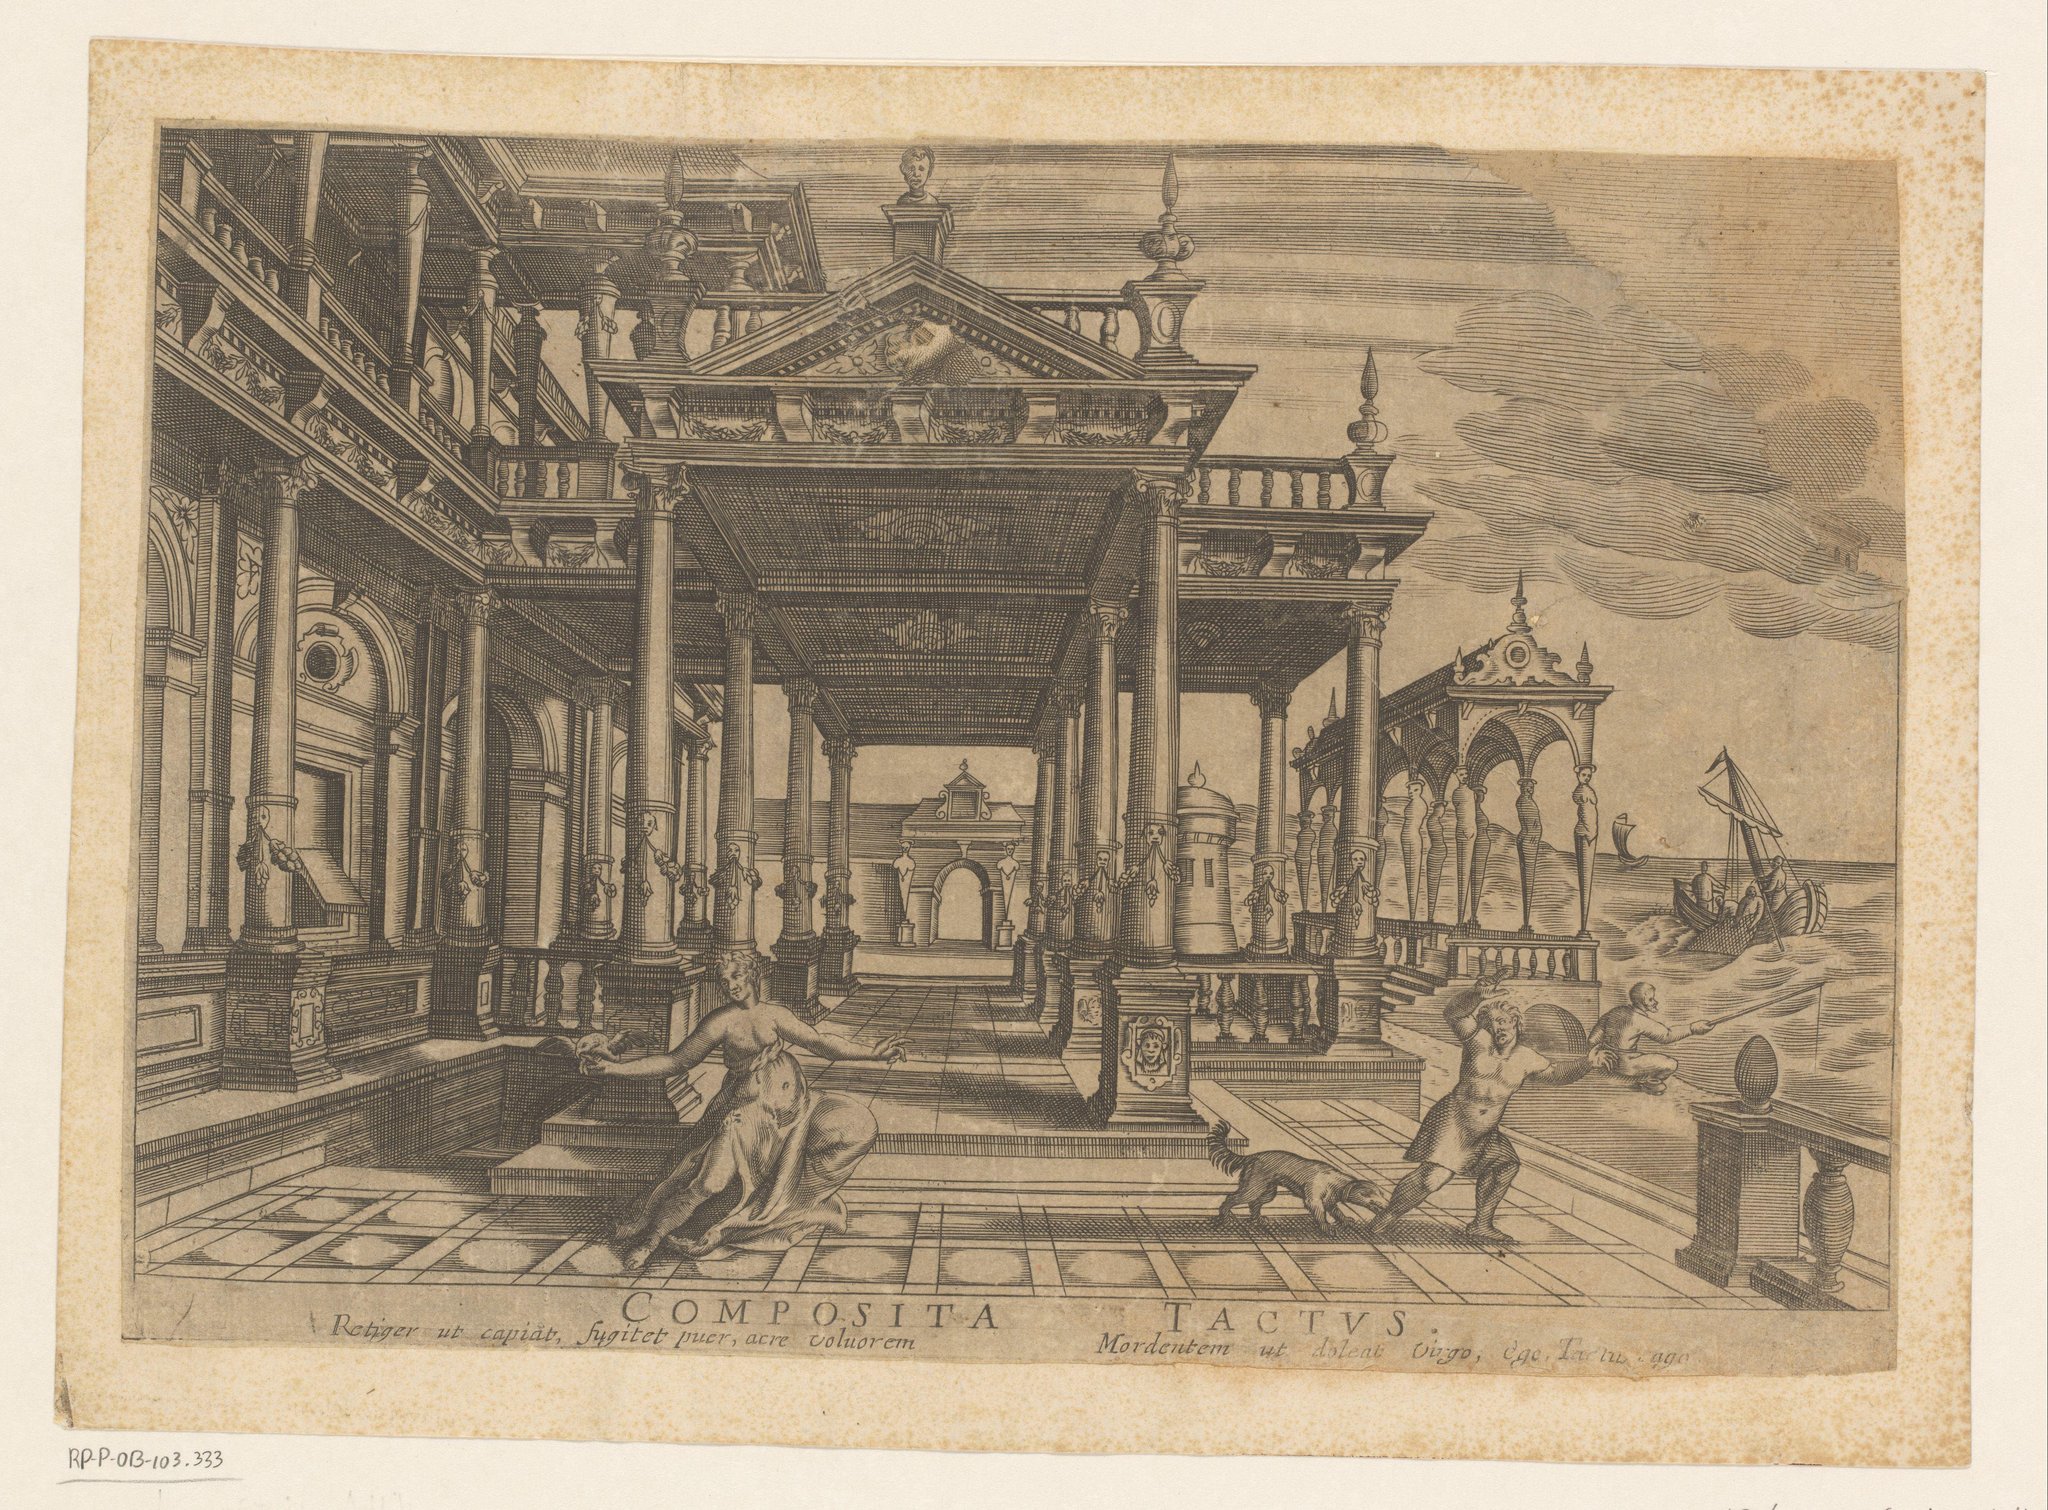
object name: print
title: Composita Tactus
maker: Anonymous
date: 1610-1680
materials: paper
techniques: engraving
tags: composite order ~ architecture, feeling (one of the five senses)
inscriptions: collector's mark: Lugt 2228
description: Portaal van een gebouw met composietzuilen. Op de voorgrond een vrouw die door een vogel in haar vinger wordt gepikt. Rechts een jongen die door een hond in zijn been wordt gebeten. Zij verbeelden het zintuig gevoel. Rechts een vissersboot op zee.